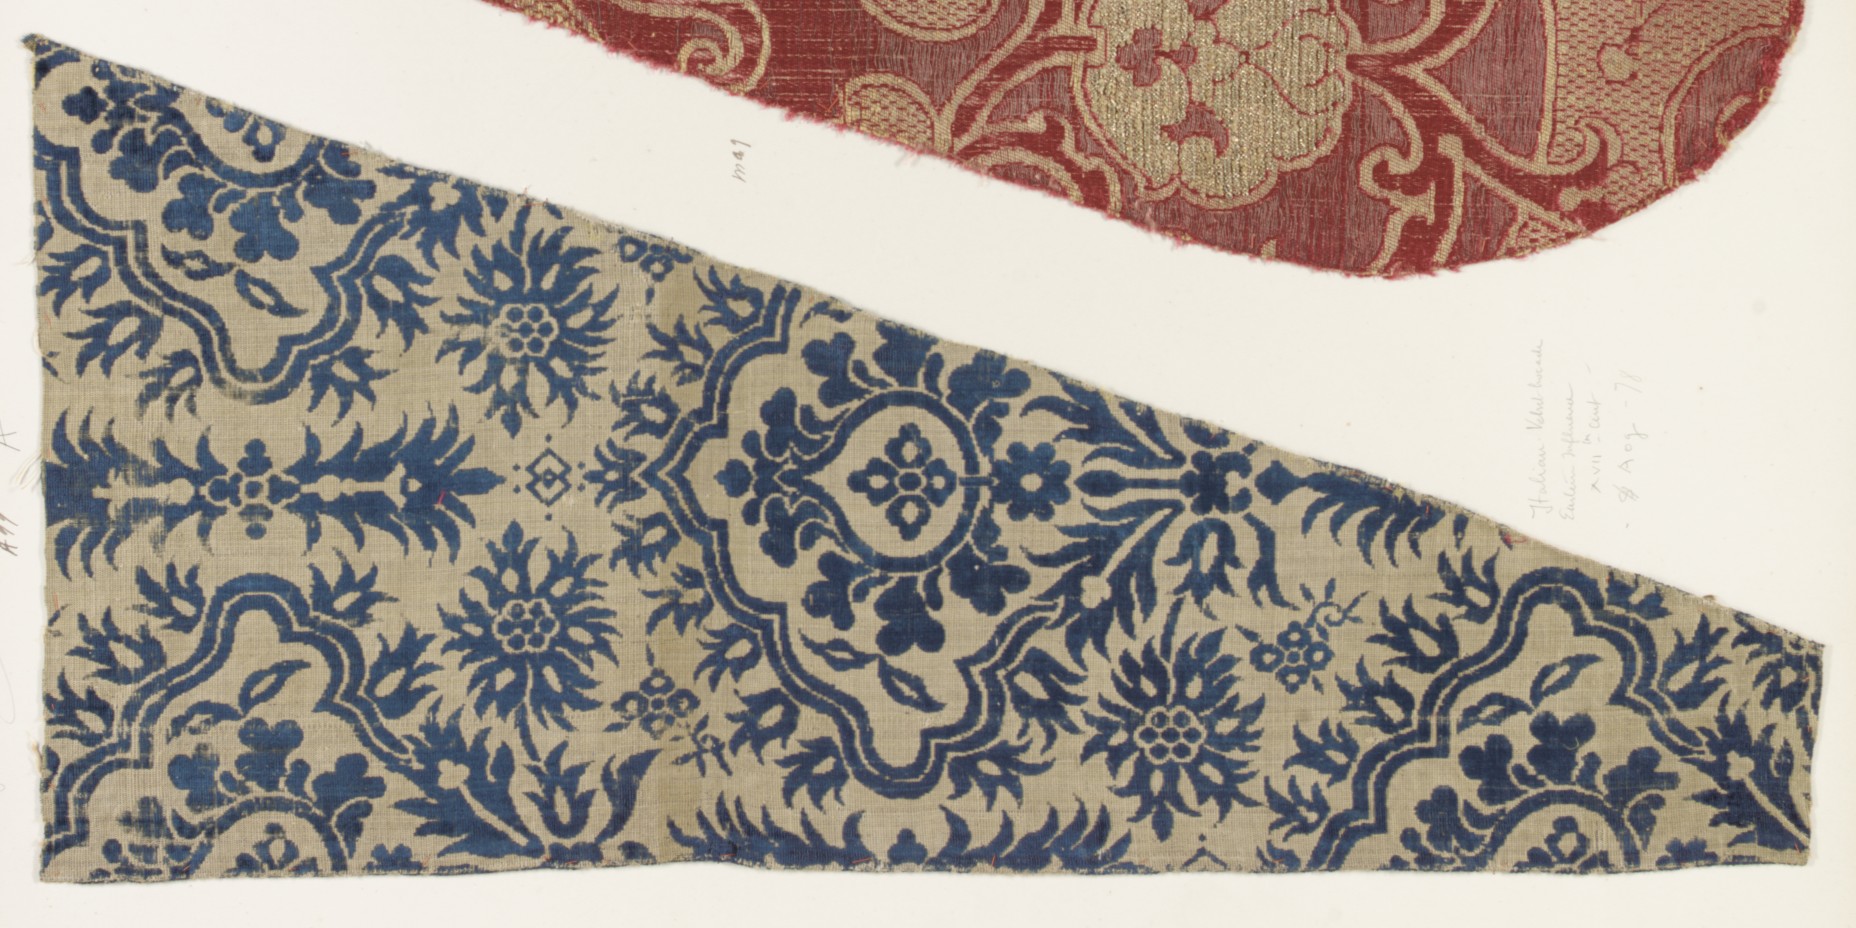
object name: fragment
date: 1601-1700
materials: silk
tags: flowers